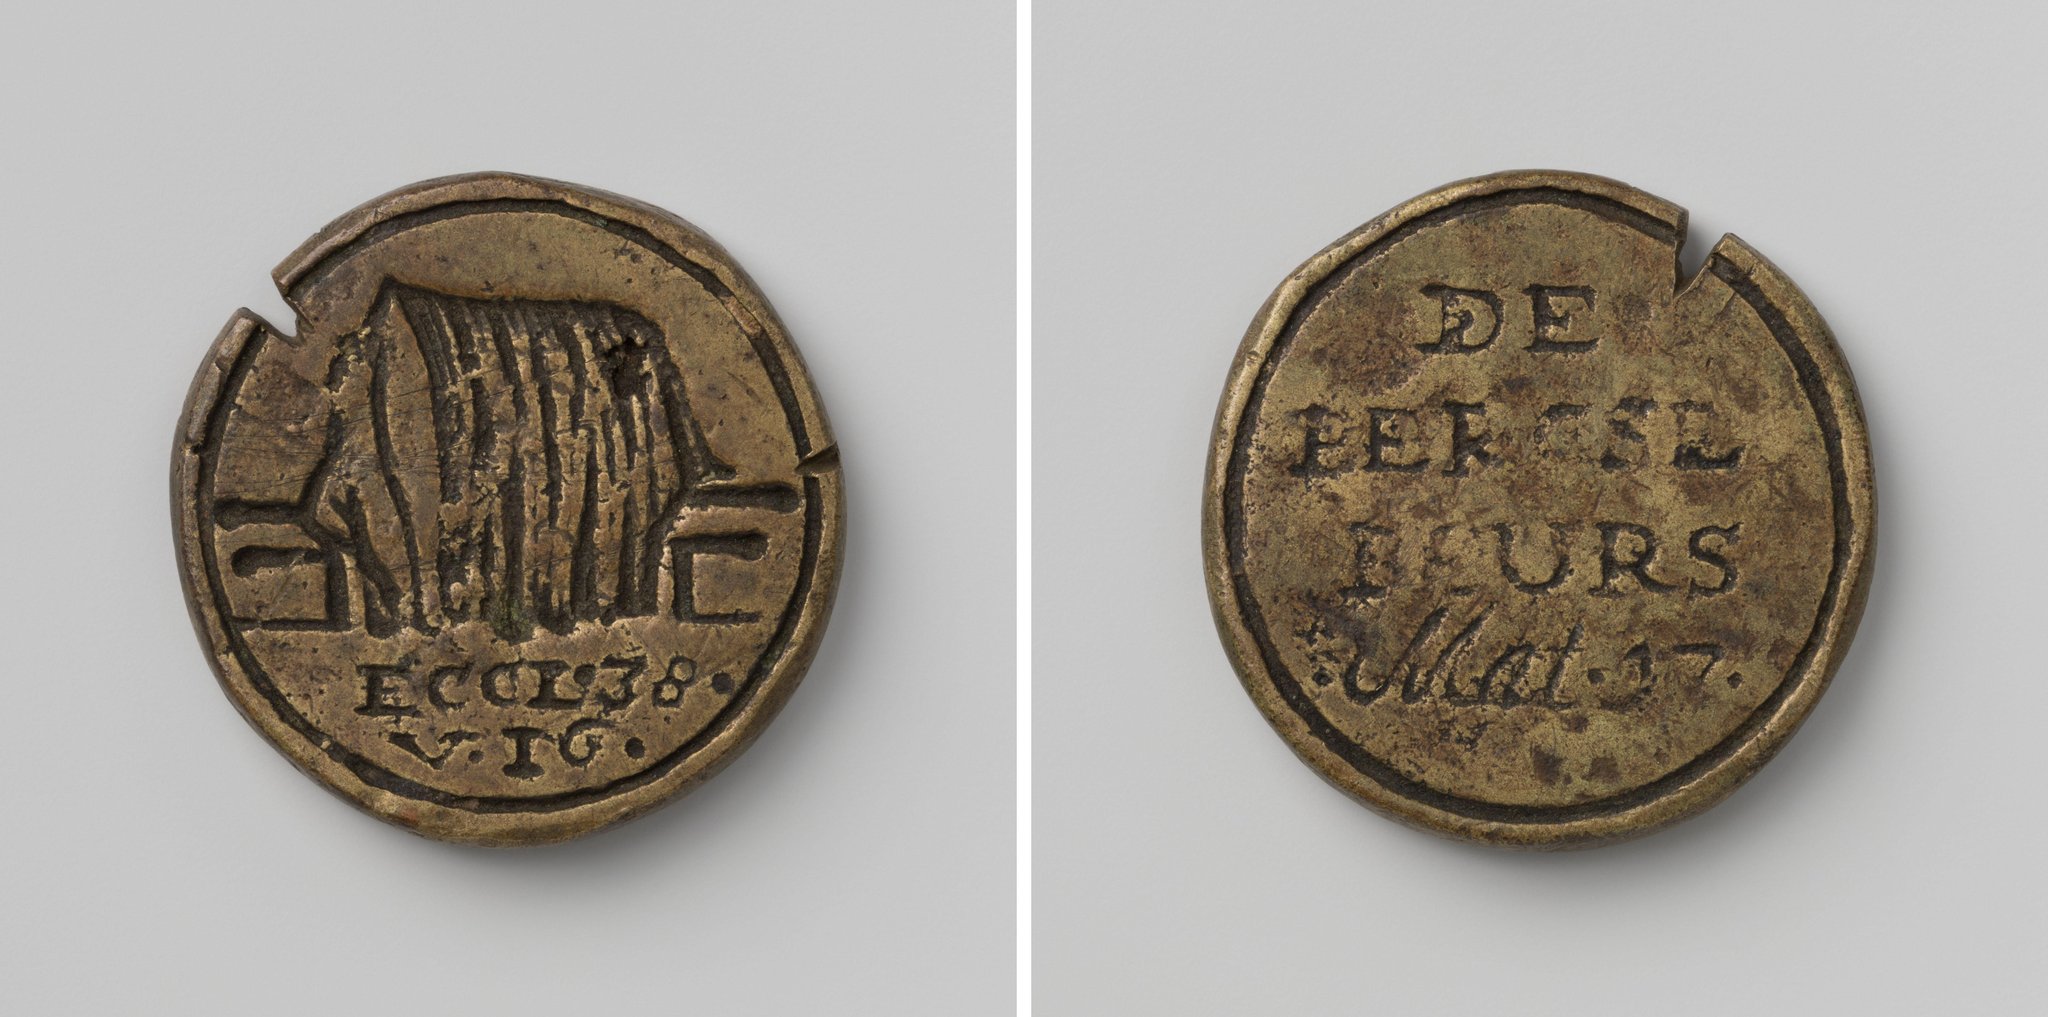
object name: buurtpenning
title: Buurt de Bergse beurs, Leiden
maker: Anonymous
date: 1600-1700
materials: brass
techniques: engraving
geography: leiden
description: Buurt de Bergse beurs, messing penning. Voorzijde: lijkbaar boven opschrift. Keerzijde: opschrift. Vermoedelijk een buurtpenning.